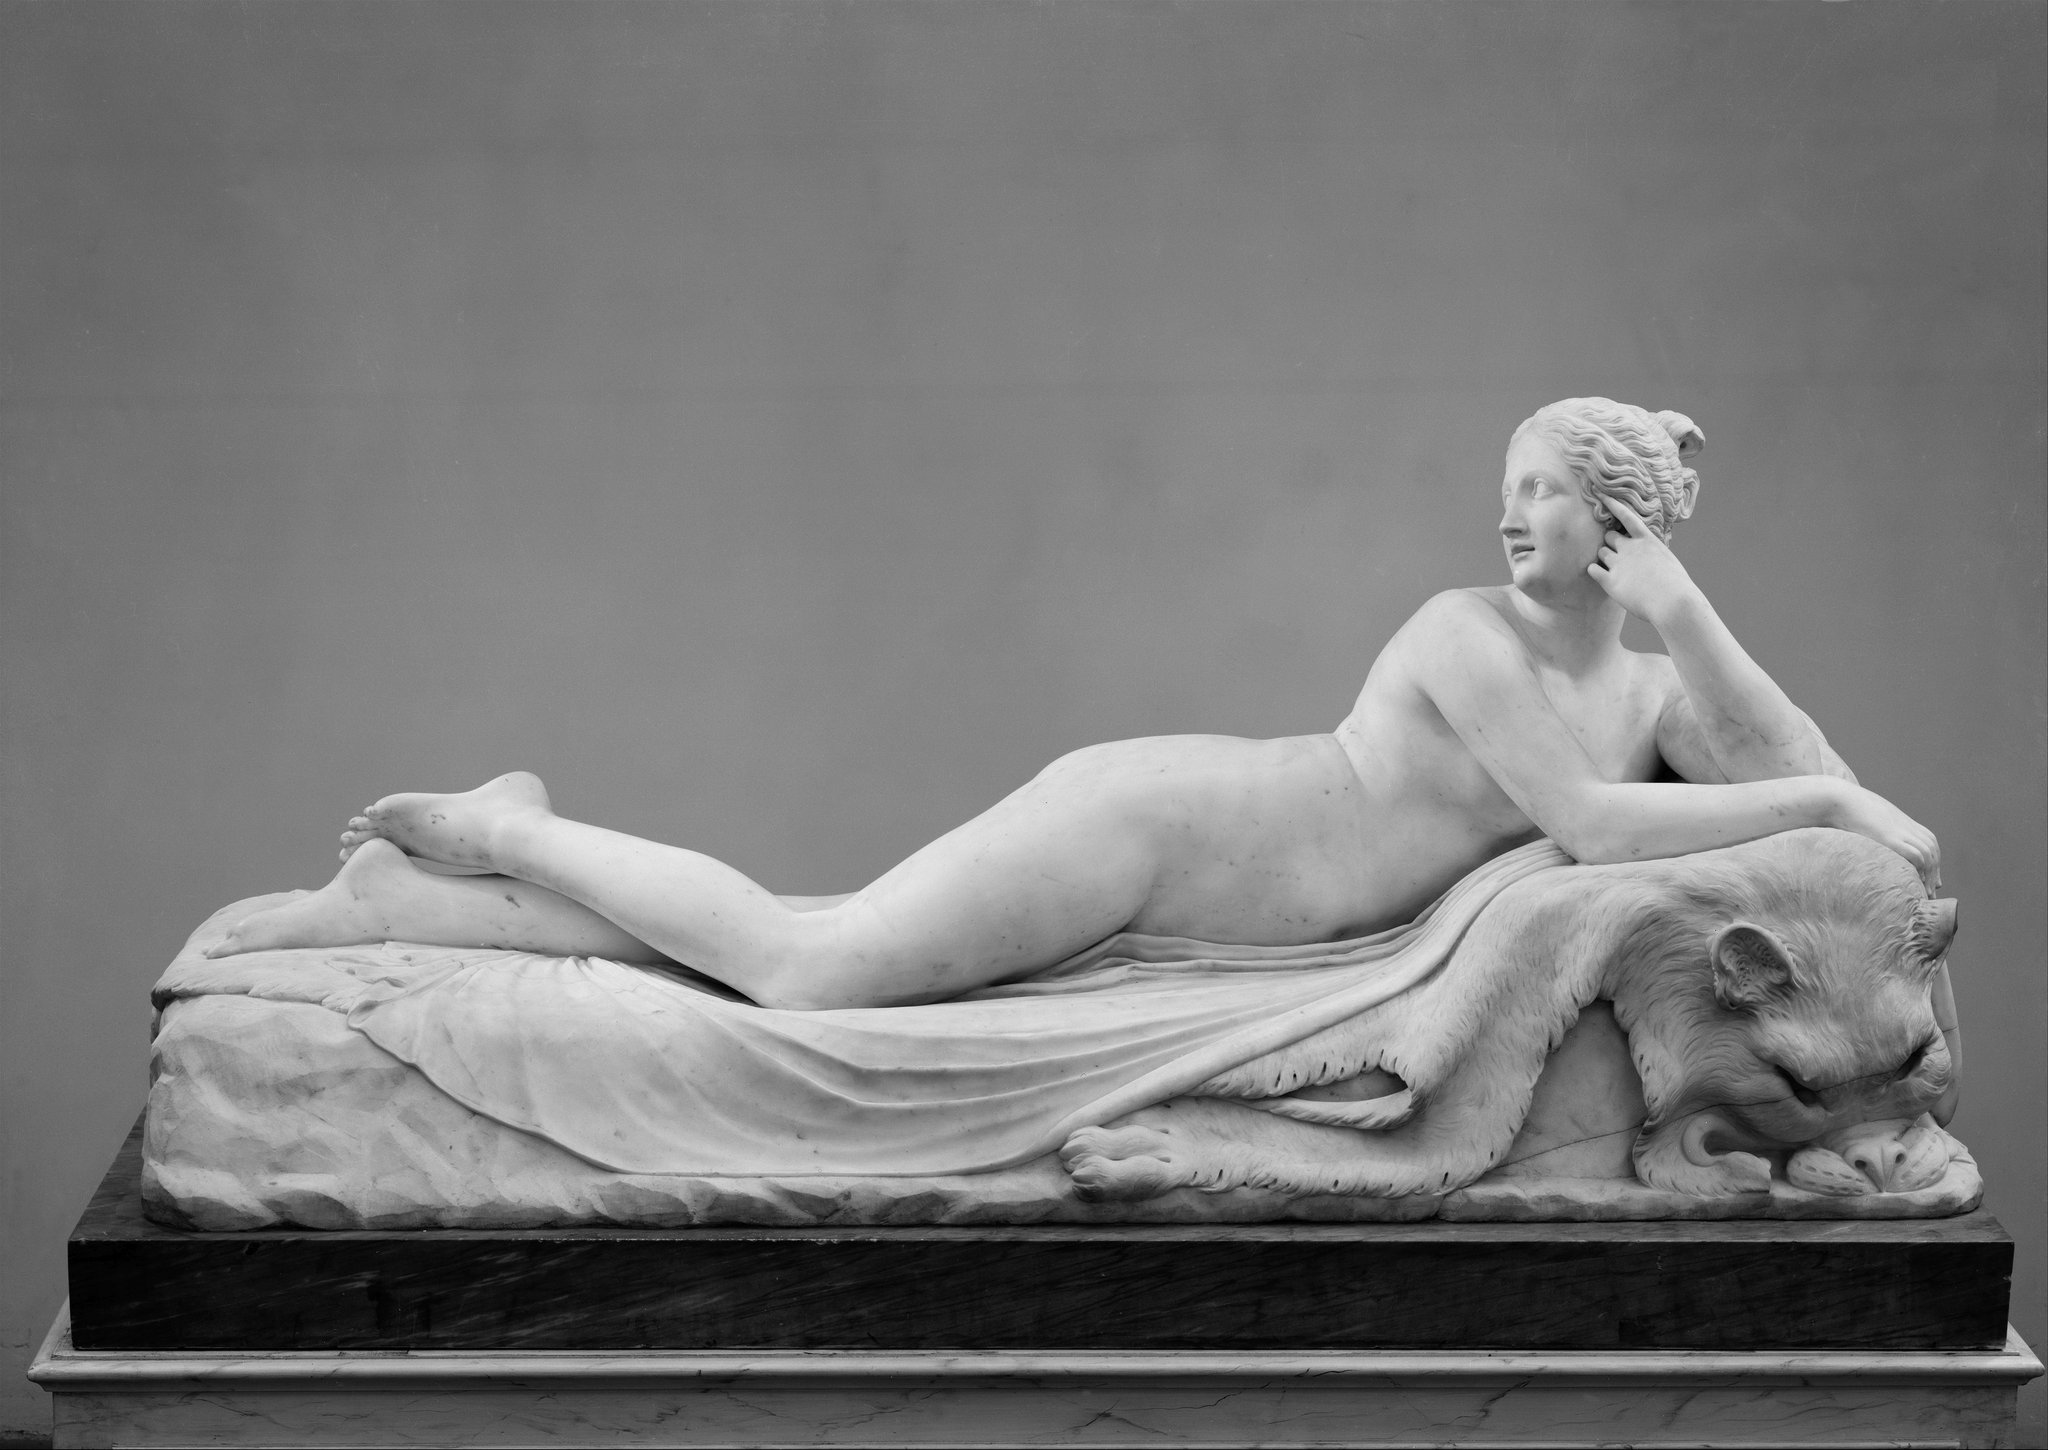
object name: statue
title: Reclining Naiad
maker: antonio canova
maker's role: maker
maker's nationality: italian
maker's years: 1757-1822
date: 1819-1824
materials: marble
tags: female nudes